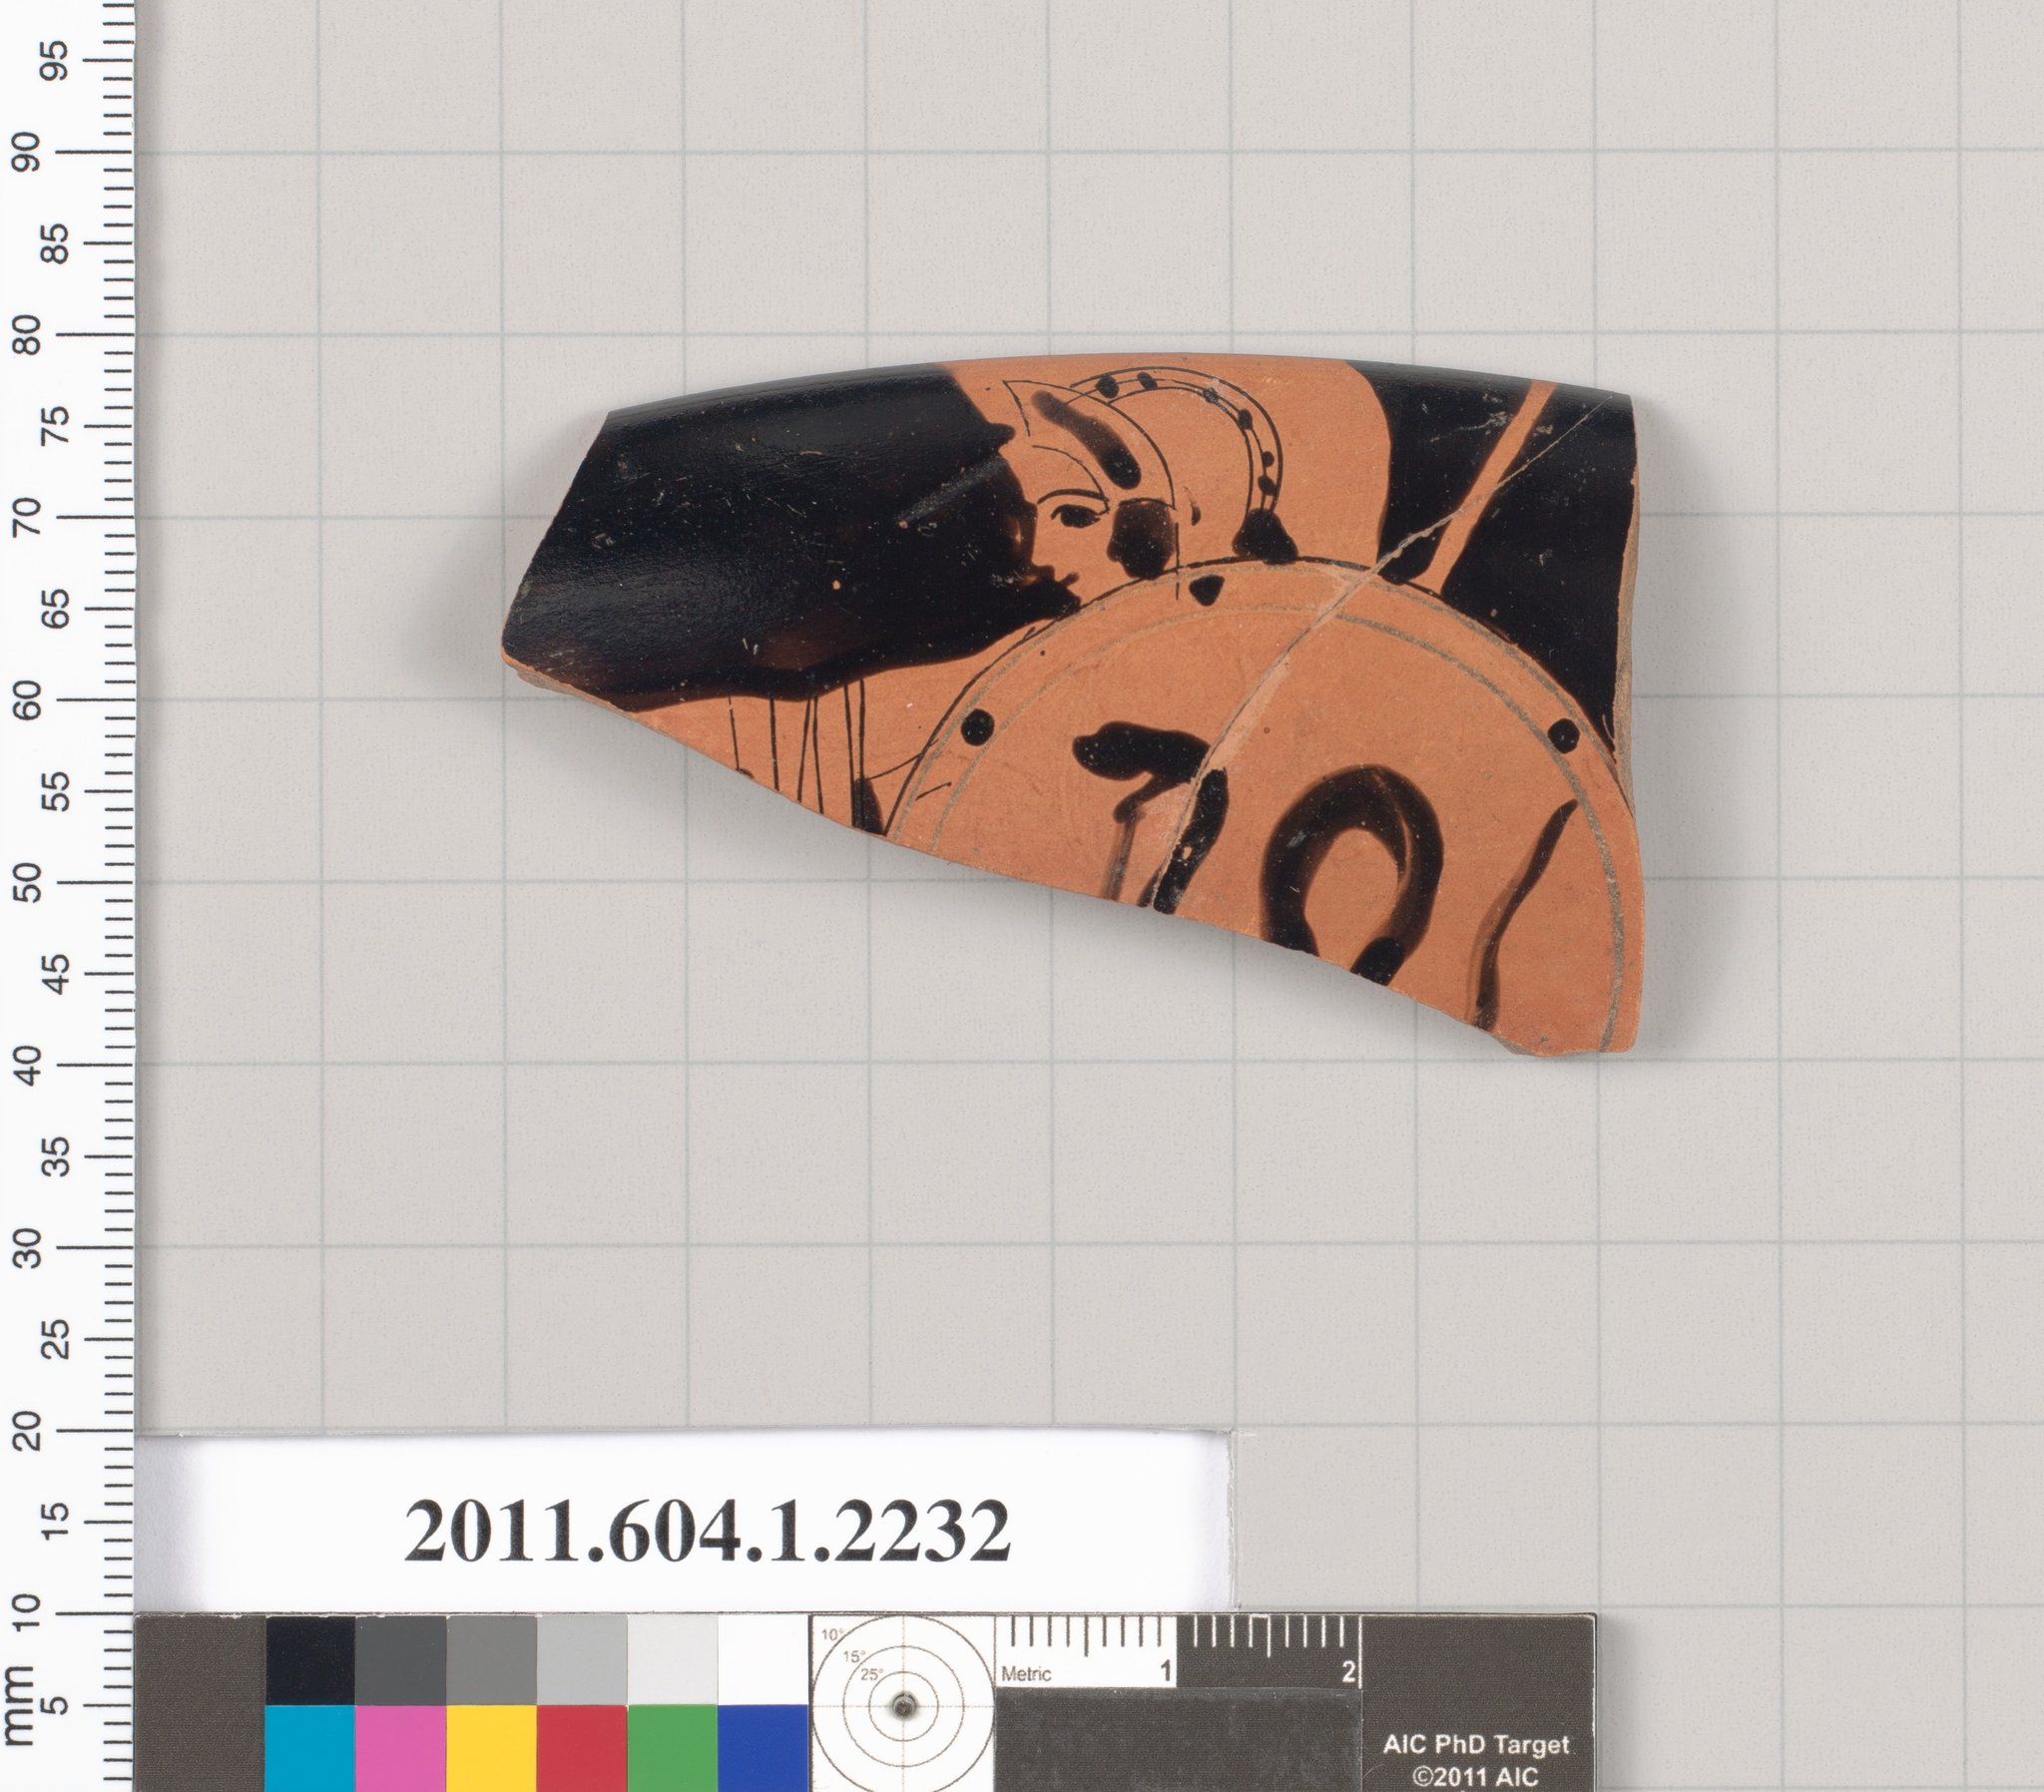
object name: kylix fragment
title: Terracotta rim fragment of a kylix (drinking cup)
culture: greek, attic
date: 475-451 BCE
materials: terracotta